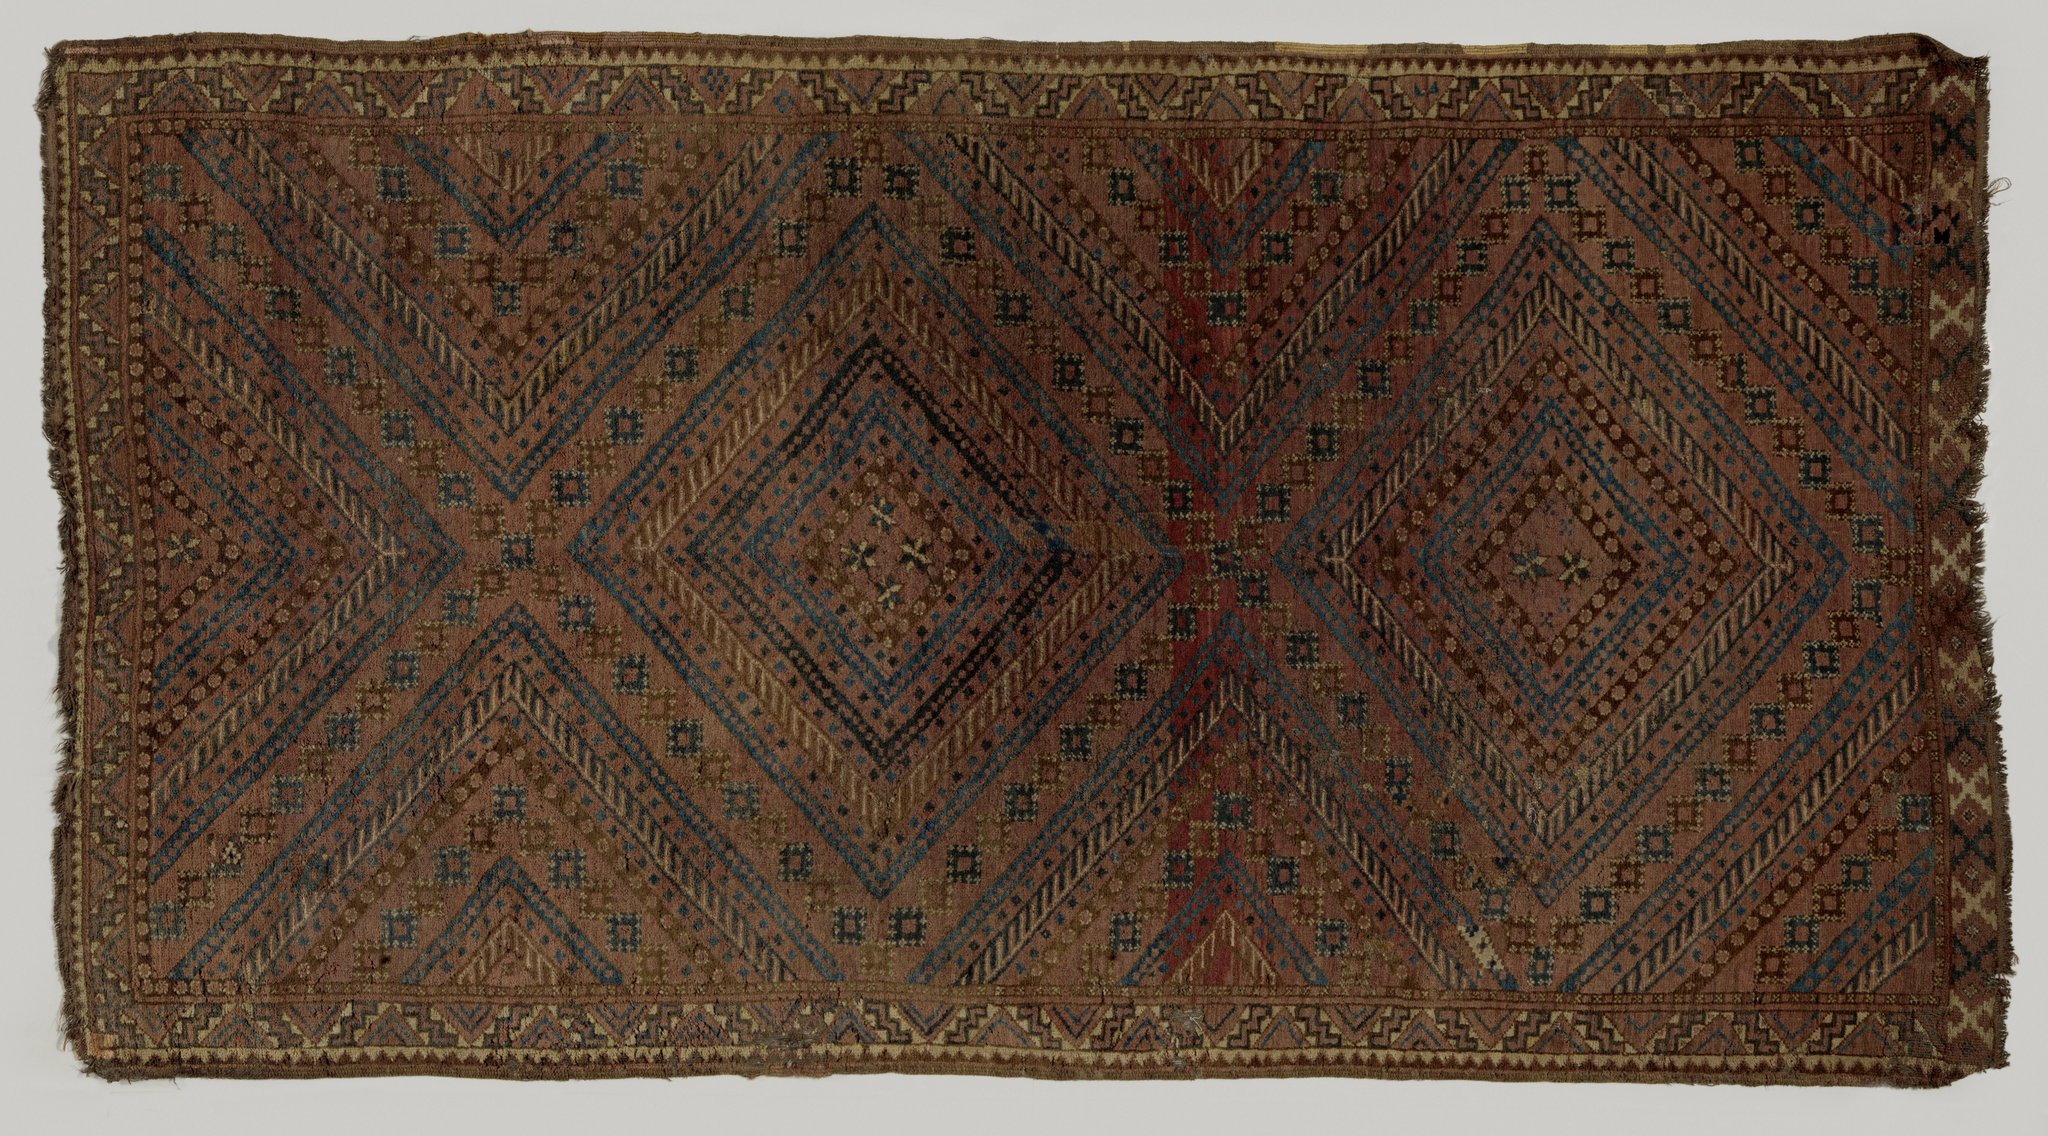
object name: oriental rug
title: Oosters tapijt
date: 1900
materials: wool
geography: central asia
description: Oosters tapijt, ruitenkleed. In het middenveld een repeterende versiering van concentrische ruiten met sterren in het hart. Rand en bovenaan een baard.